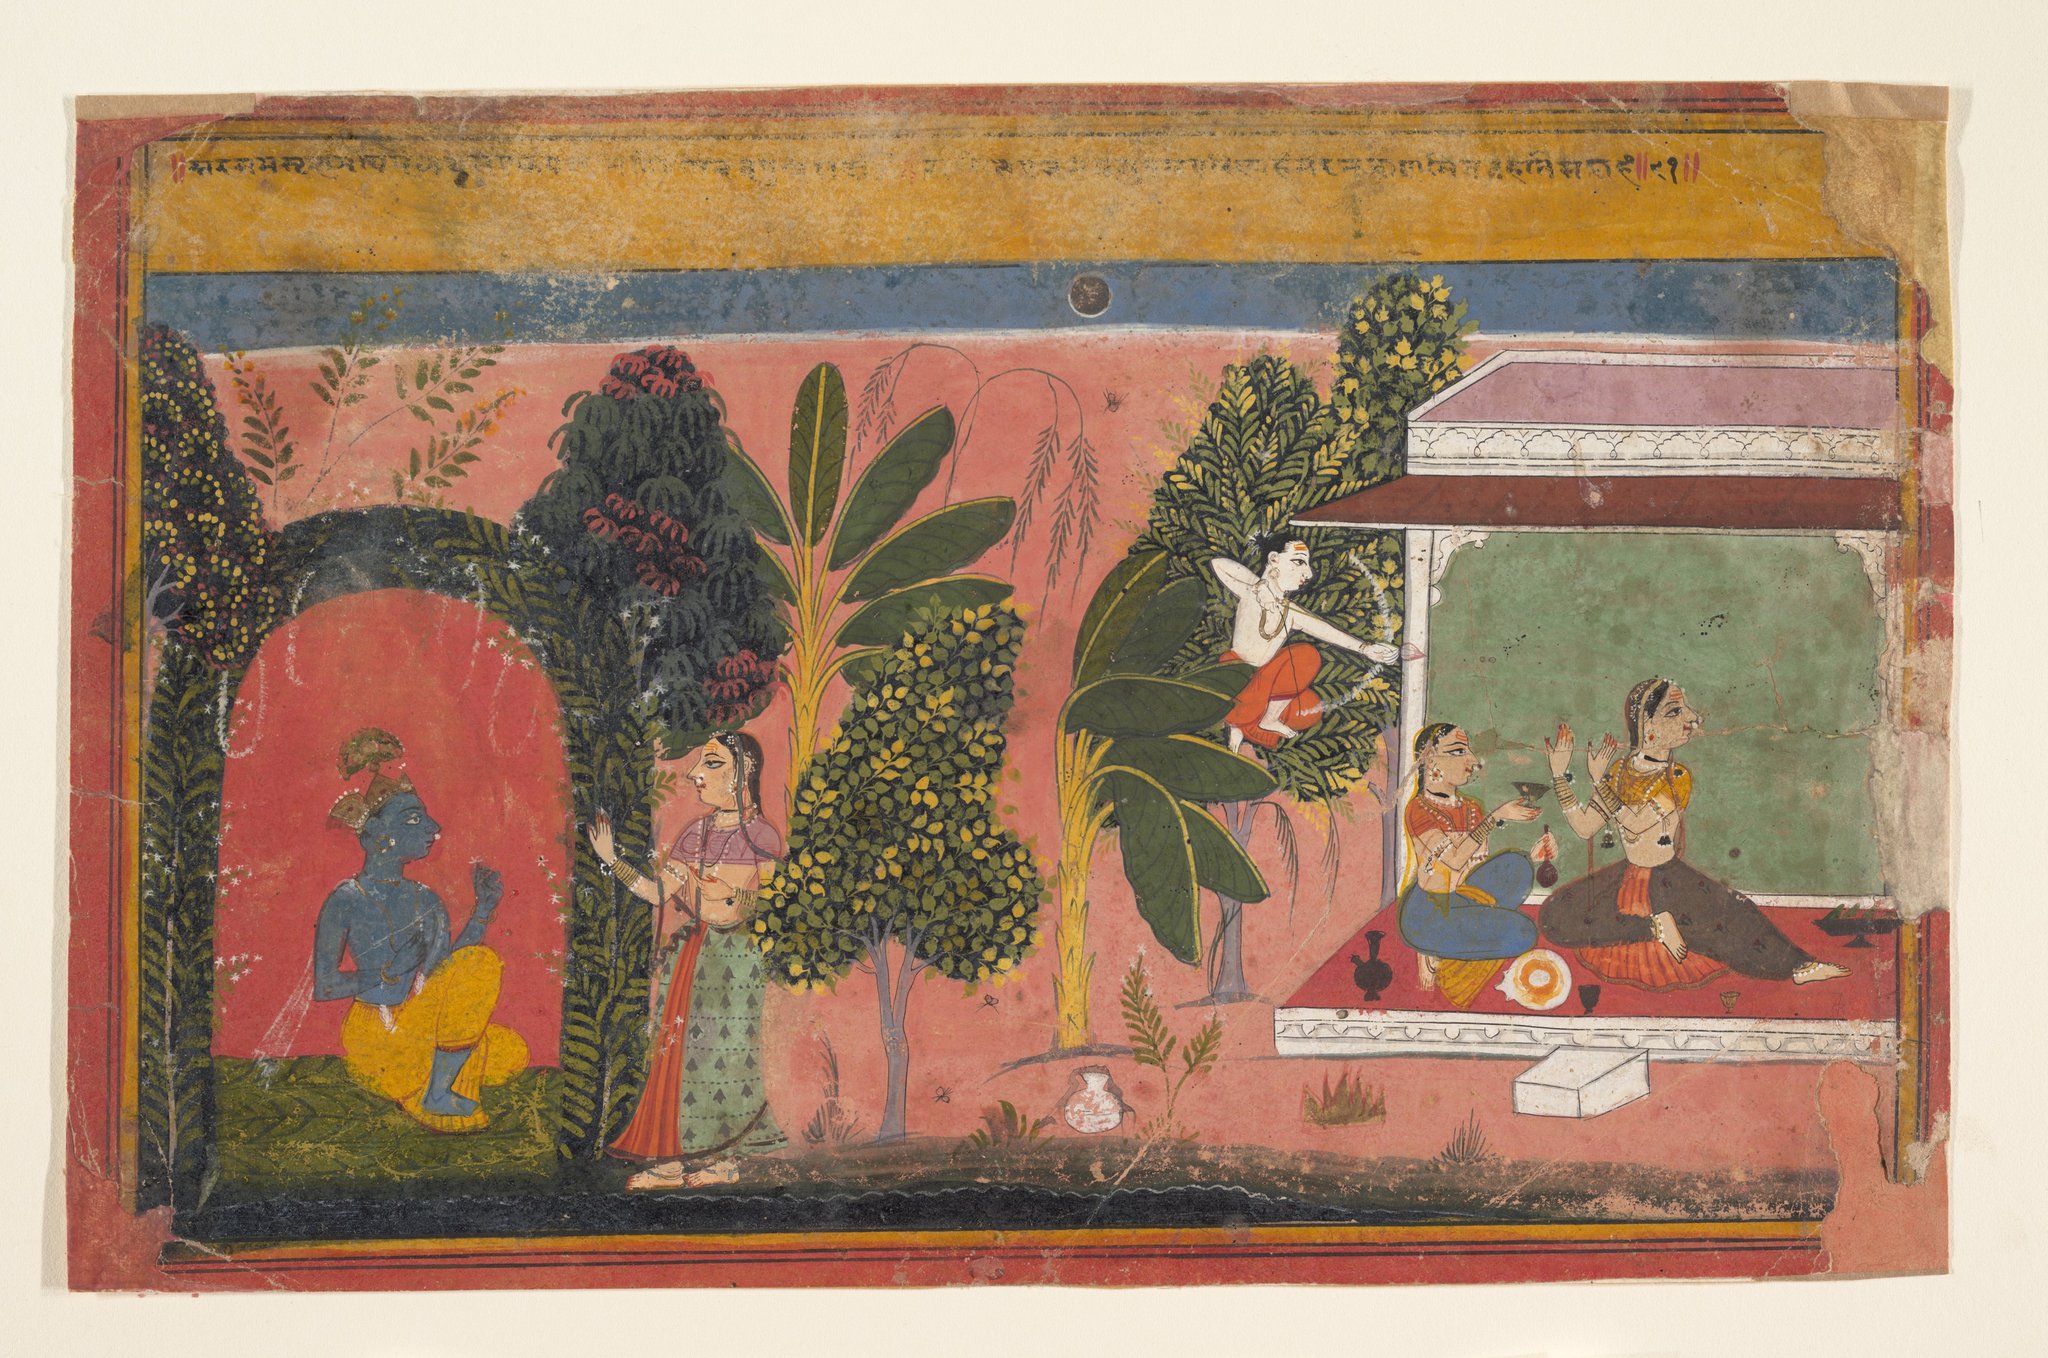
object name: folio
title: Kama Aims His Bow at Radha: Page From a Dispersed Gita Govinda (Loves of Krishna)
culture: mewar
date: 1695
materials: ink, paper, watercolor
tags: bow and arrow,men,women,krishna,radha